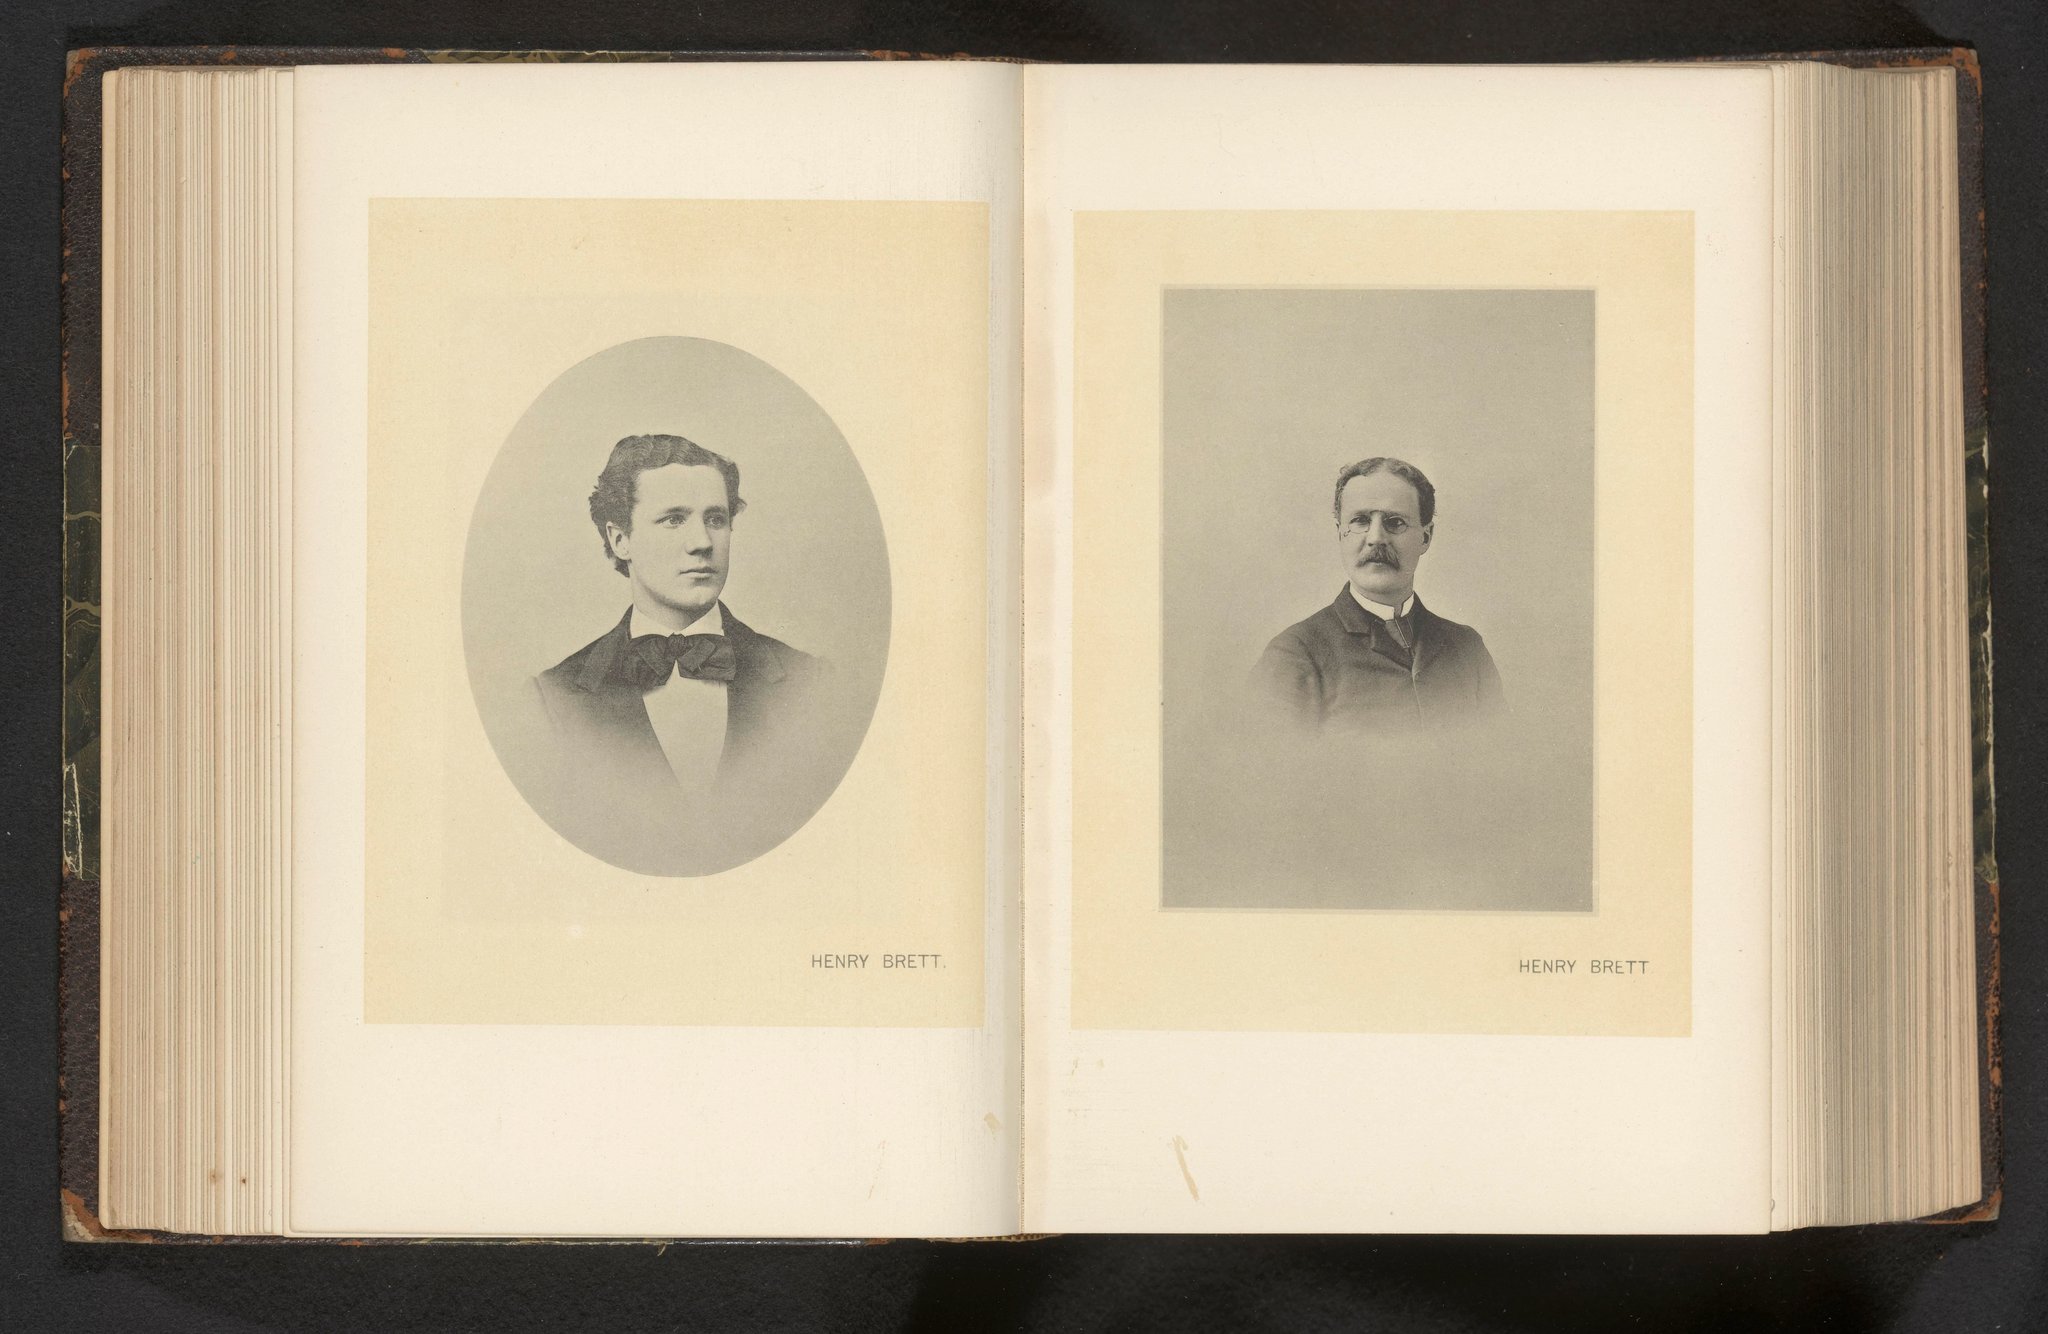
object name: photomechanical print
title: Henry Brett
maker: Anonymous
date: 1869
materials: paper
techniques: photoaquatint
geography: boston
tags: adult man